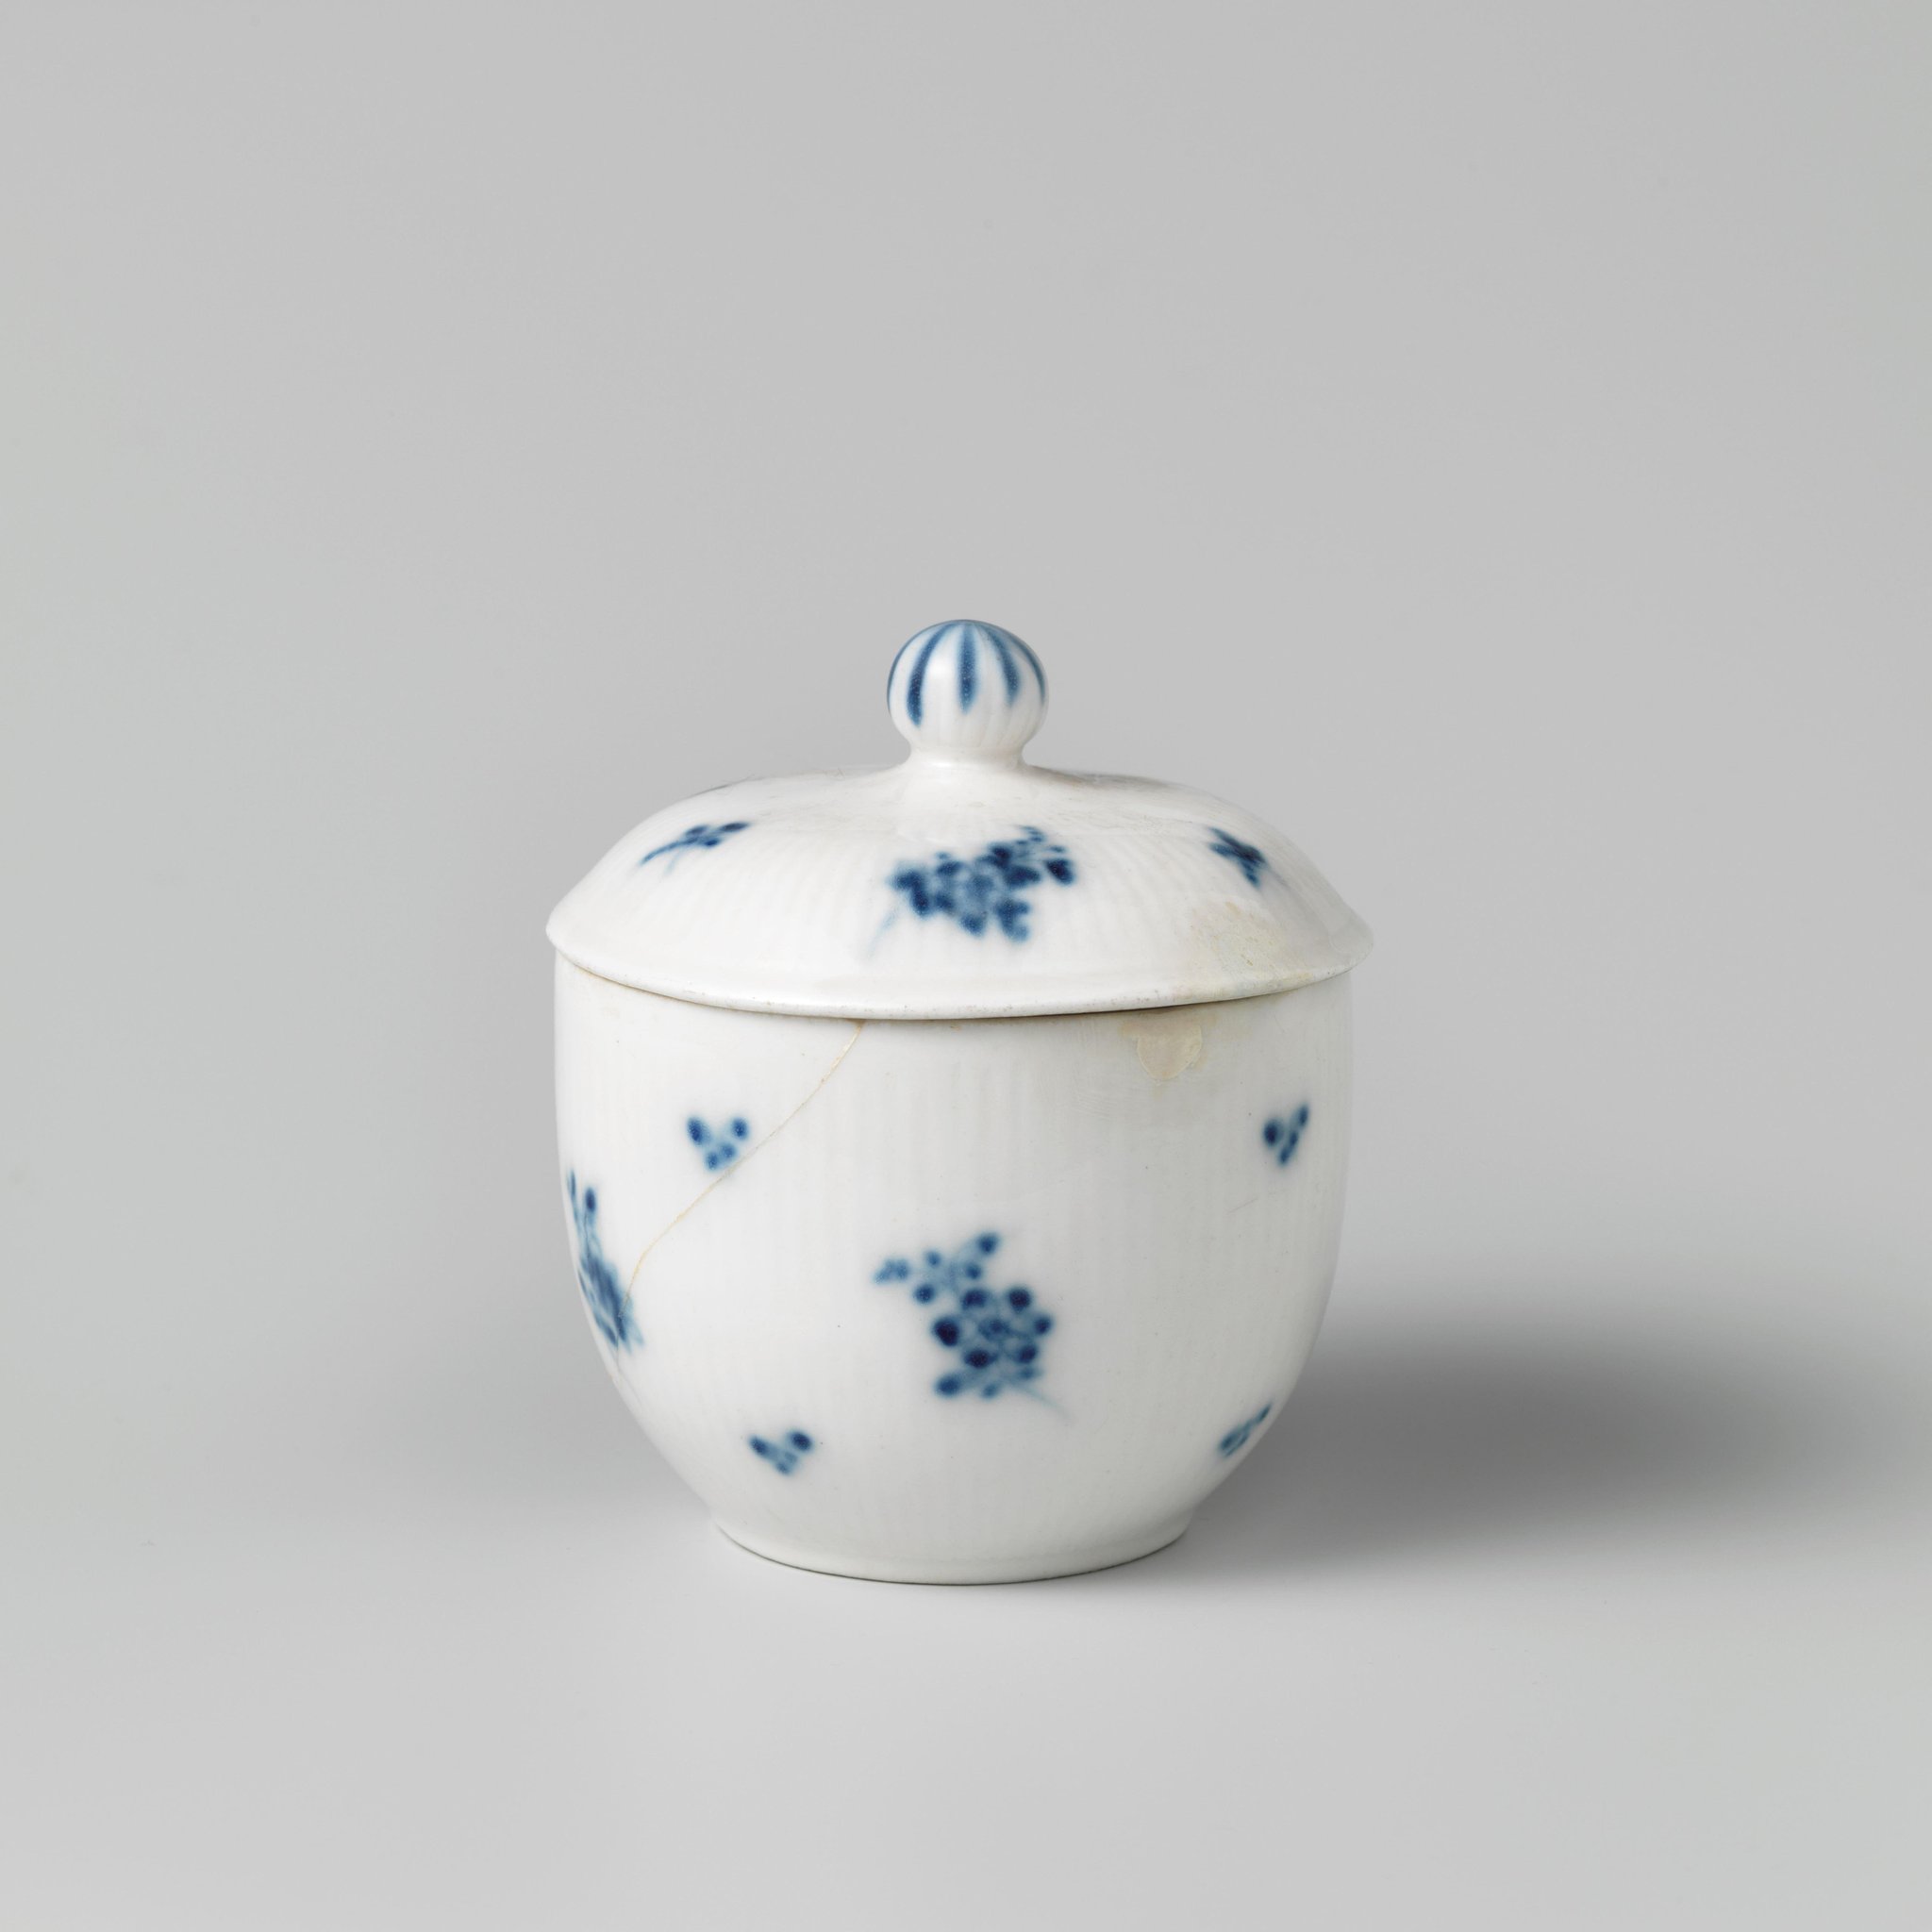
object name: sugar box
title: Suikerpot, beschilderd met strooibloemen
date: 1784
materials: porcelain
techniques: painted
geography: ouder-amstel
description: Delen van een koffie- en theeservies bestaande uit een koffiekan, een theepot, een melkkan en een suikerpot geribd met een blauw strooipatroon van bloemen onder het glazuur. Gemerkt: koffiekan Amstel in blauw, theepot M:O L in blauw en ingegrift, melkkan MOL en Amstel in blauw en suikerpot * M:OL in blauw en ingegrift M:OL L80.